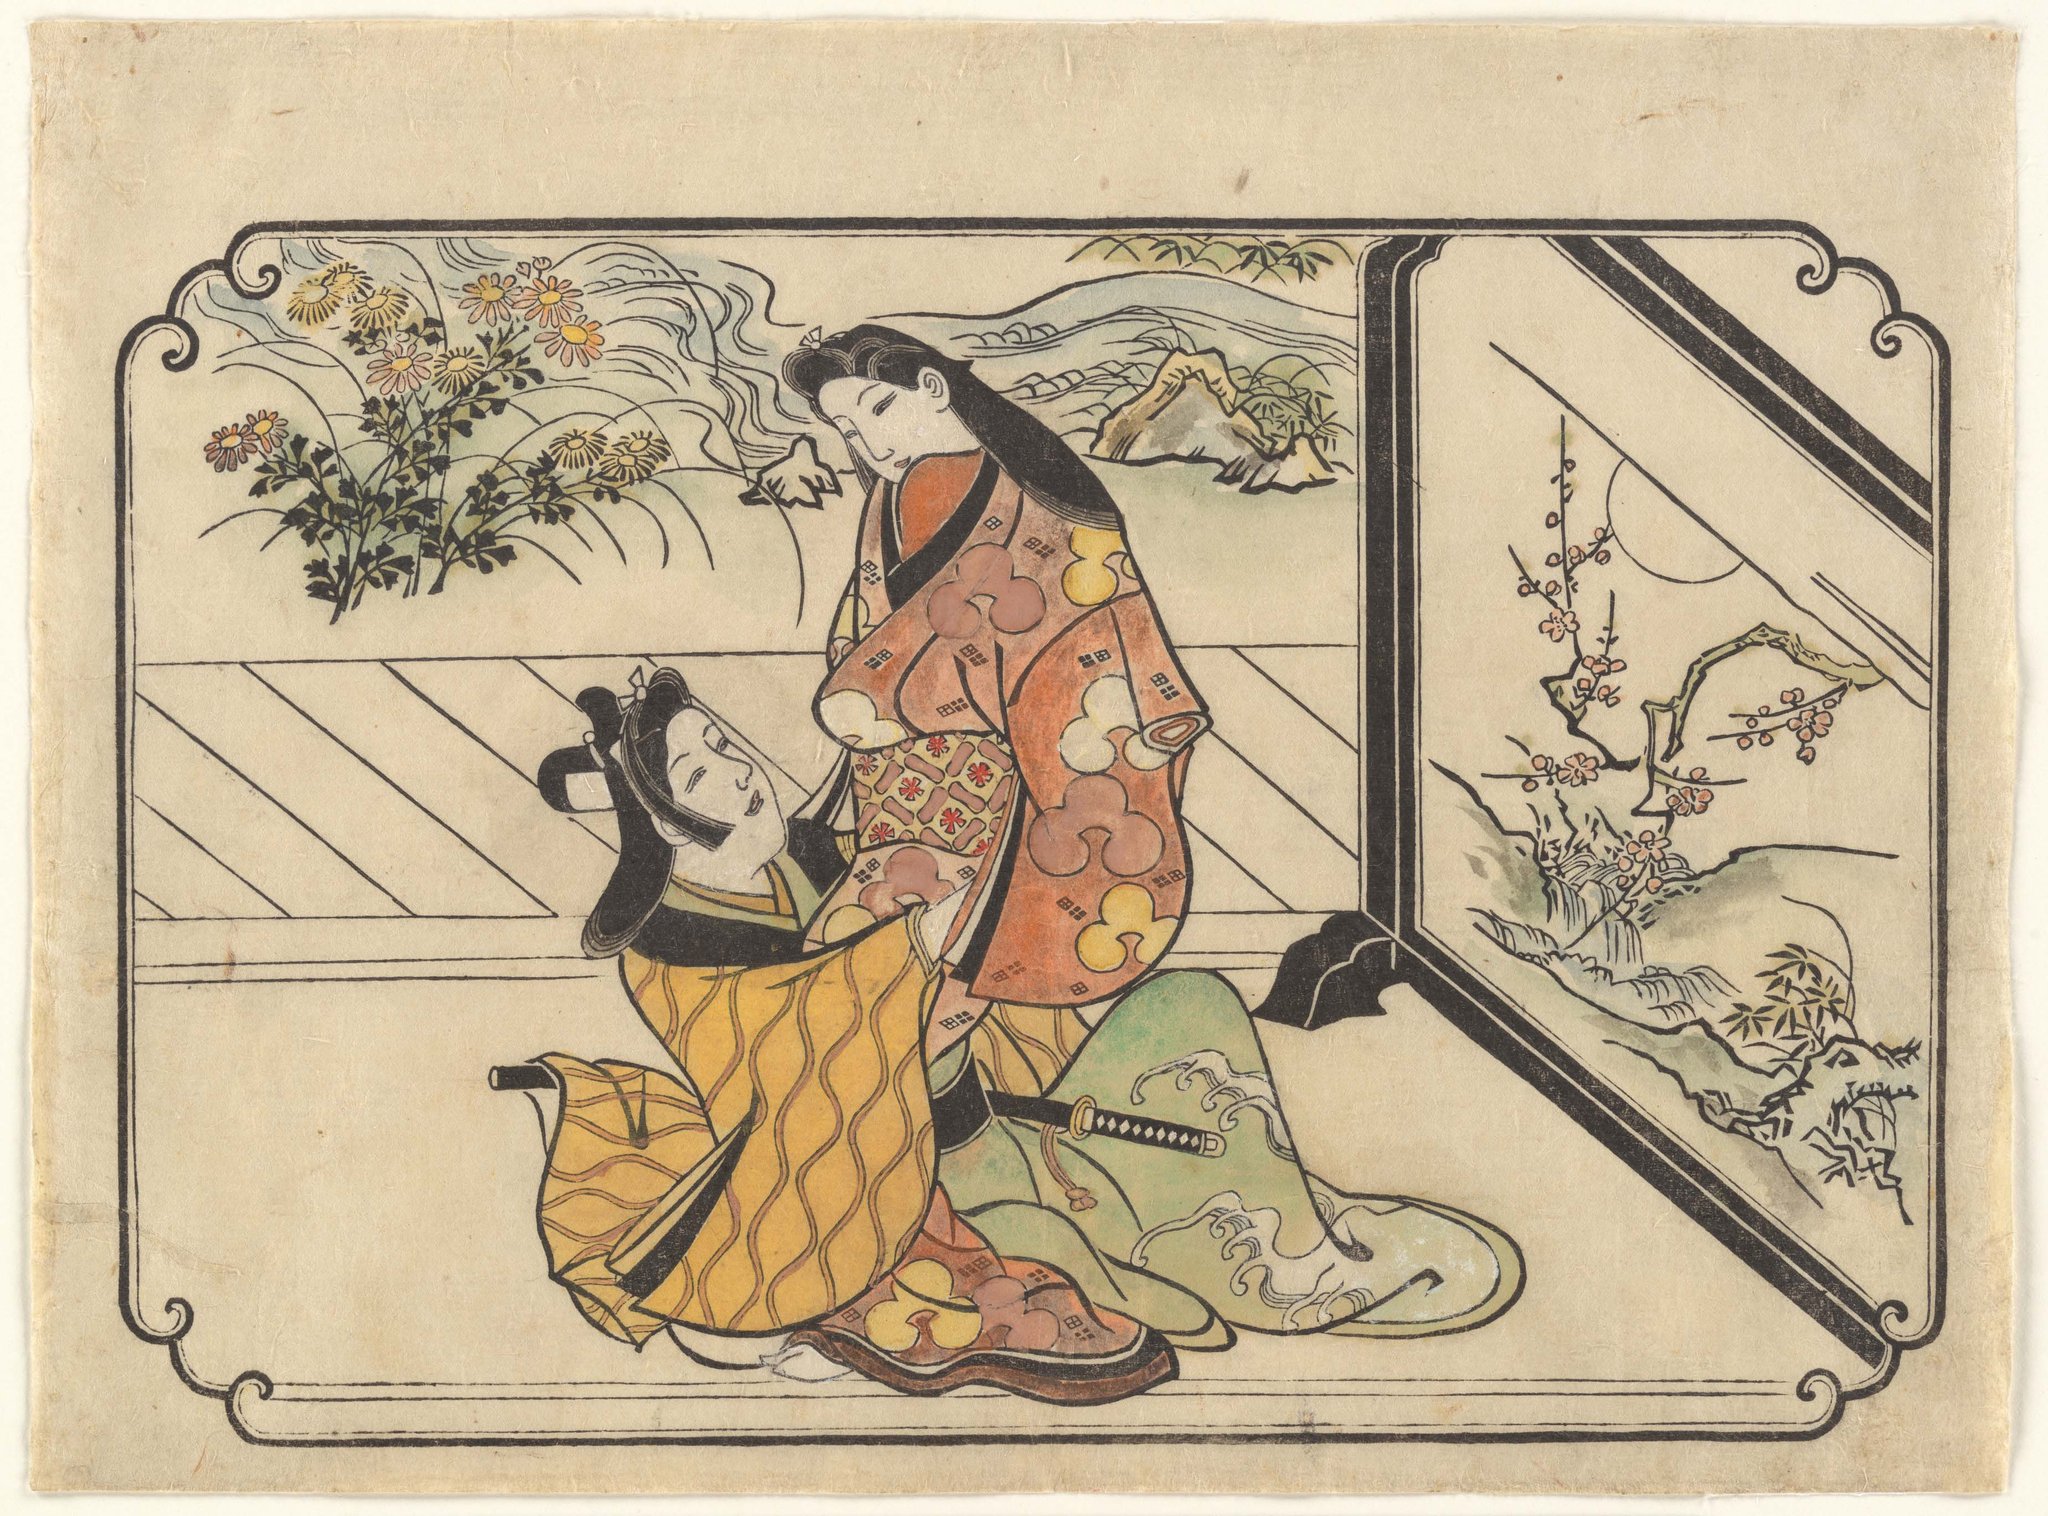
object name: woodblock print sumizuri e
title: Courtesan with a Young Man (Wakashu) beside a Screen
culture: japanese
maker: hishikawa moronobu 菱川師宣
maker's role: artist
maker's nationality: japanese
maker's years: 1618-1694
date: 1679-1684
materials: ink, paper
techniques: sumizuri, woodblock print